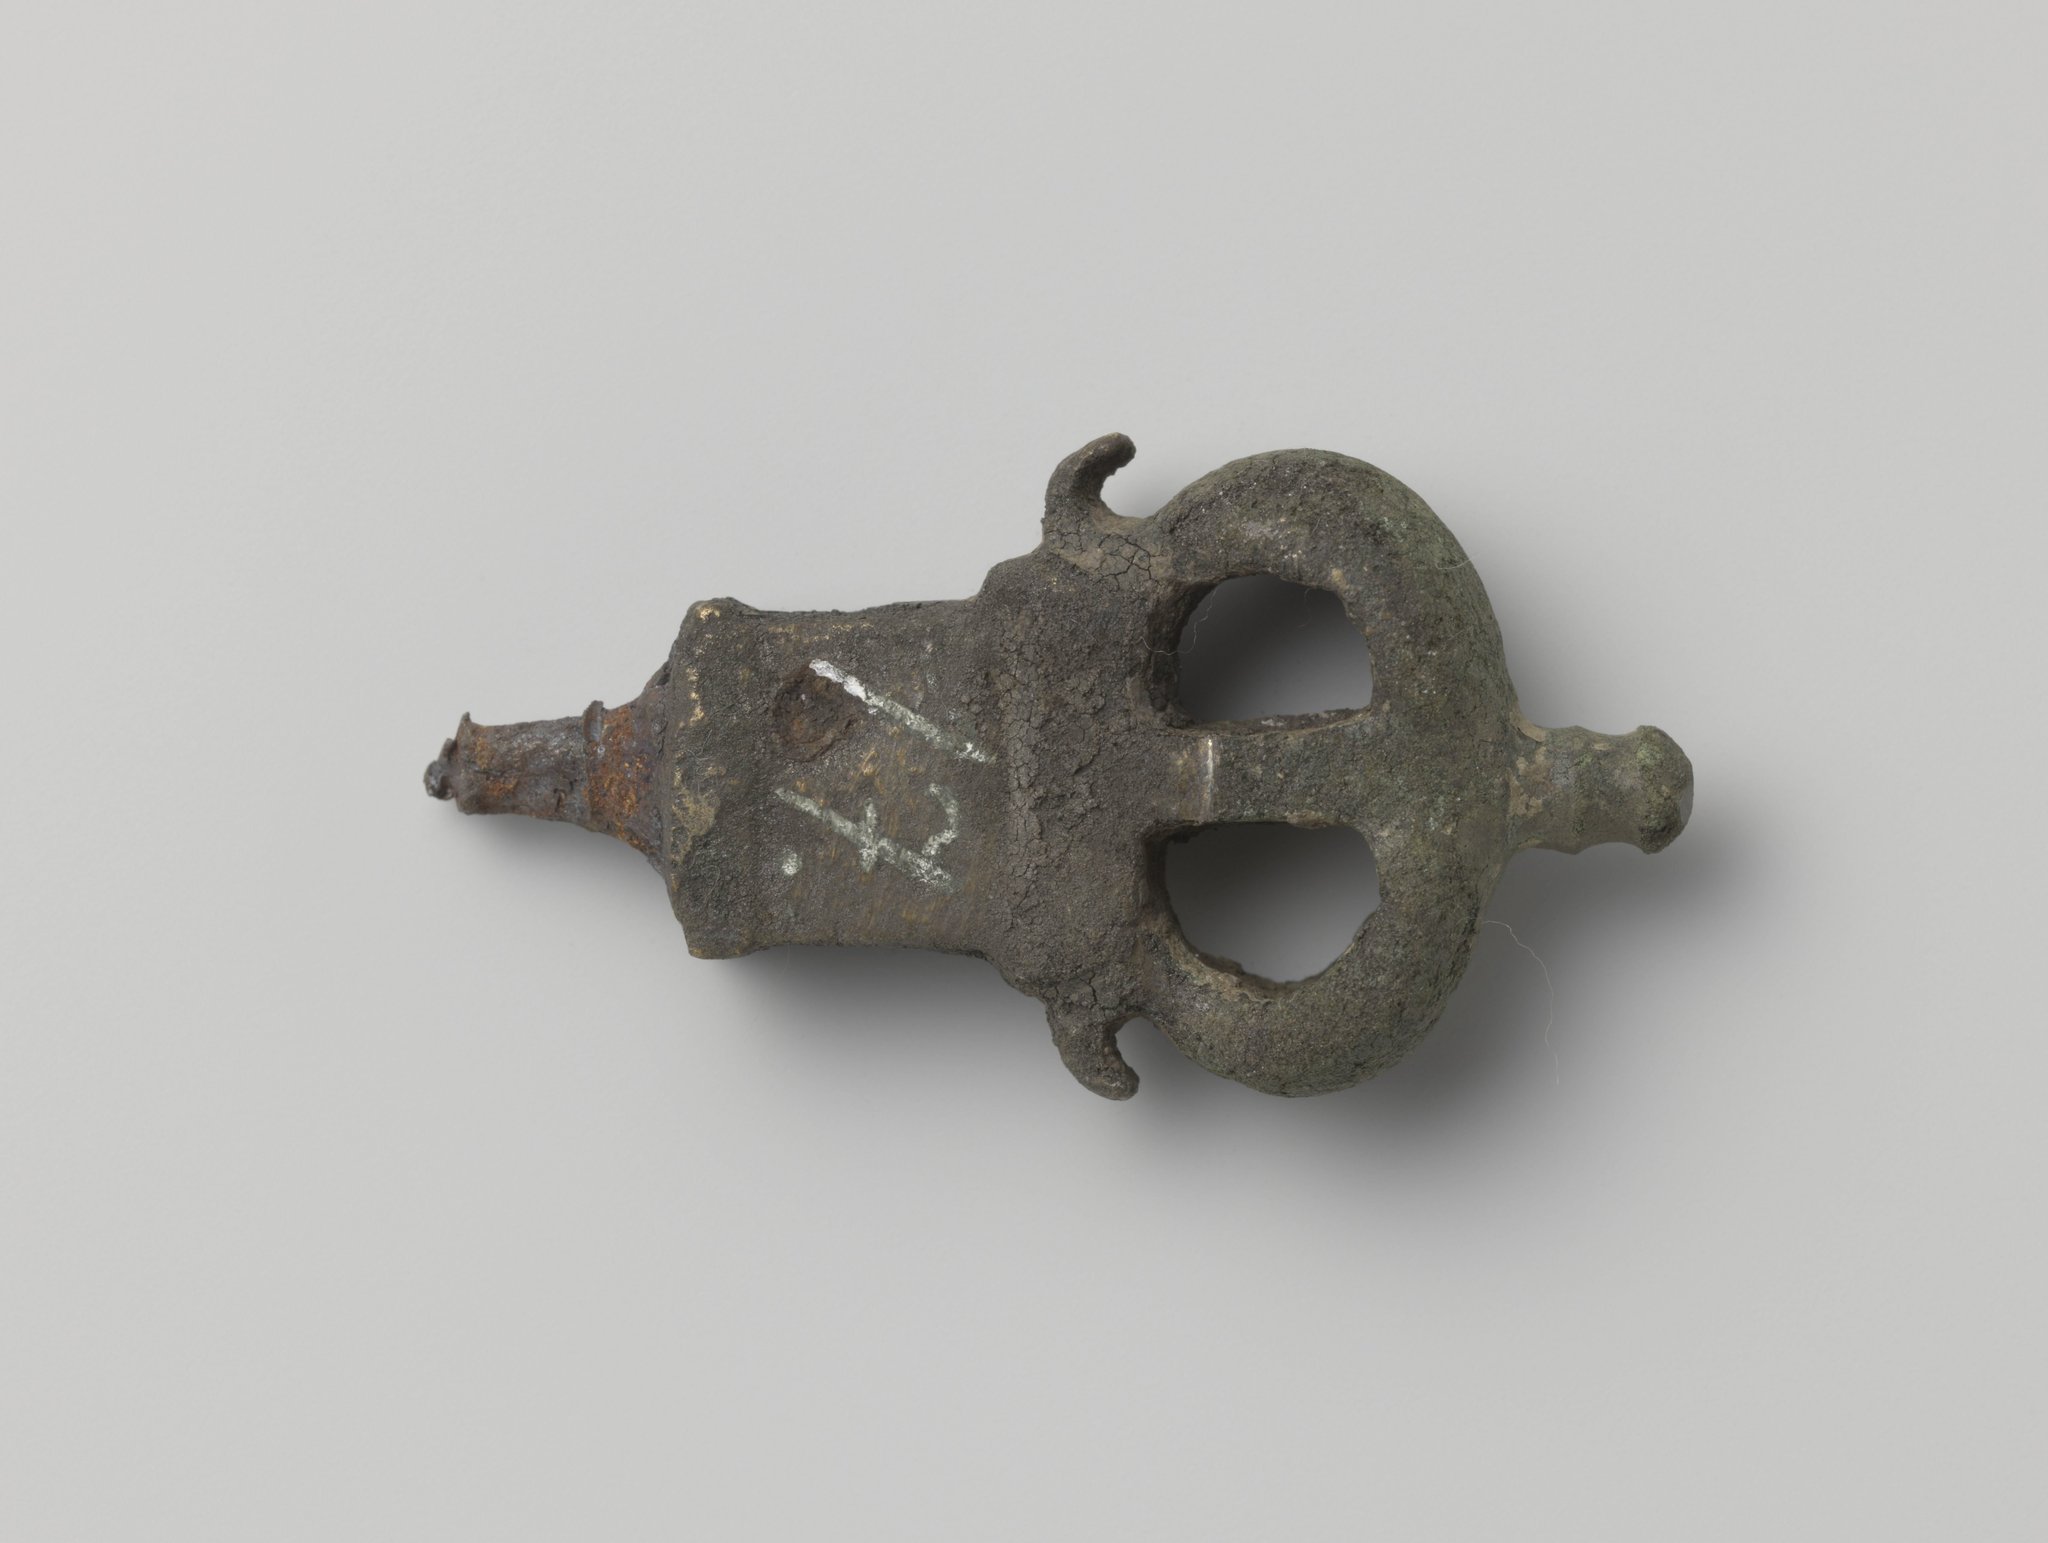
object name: key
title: Sleutelgreep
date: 1400-1950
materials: bronze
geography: rome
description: Sleutelgreep, kroonvormig, met een restant van de ijzeren steel. Op de kroon een geprofileerd knopje.